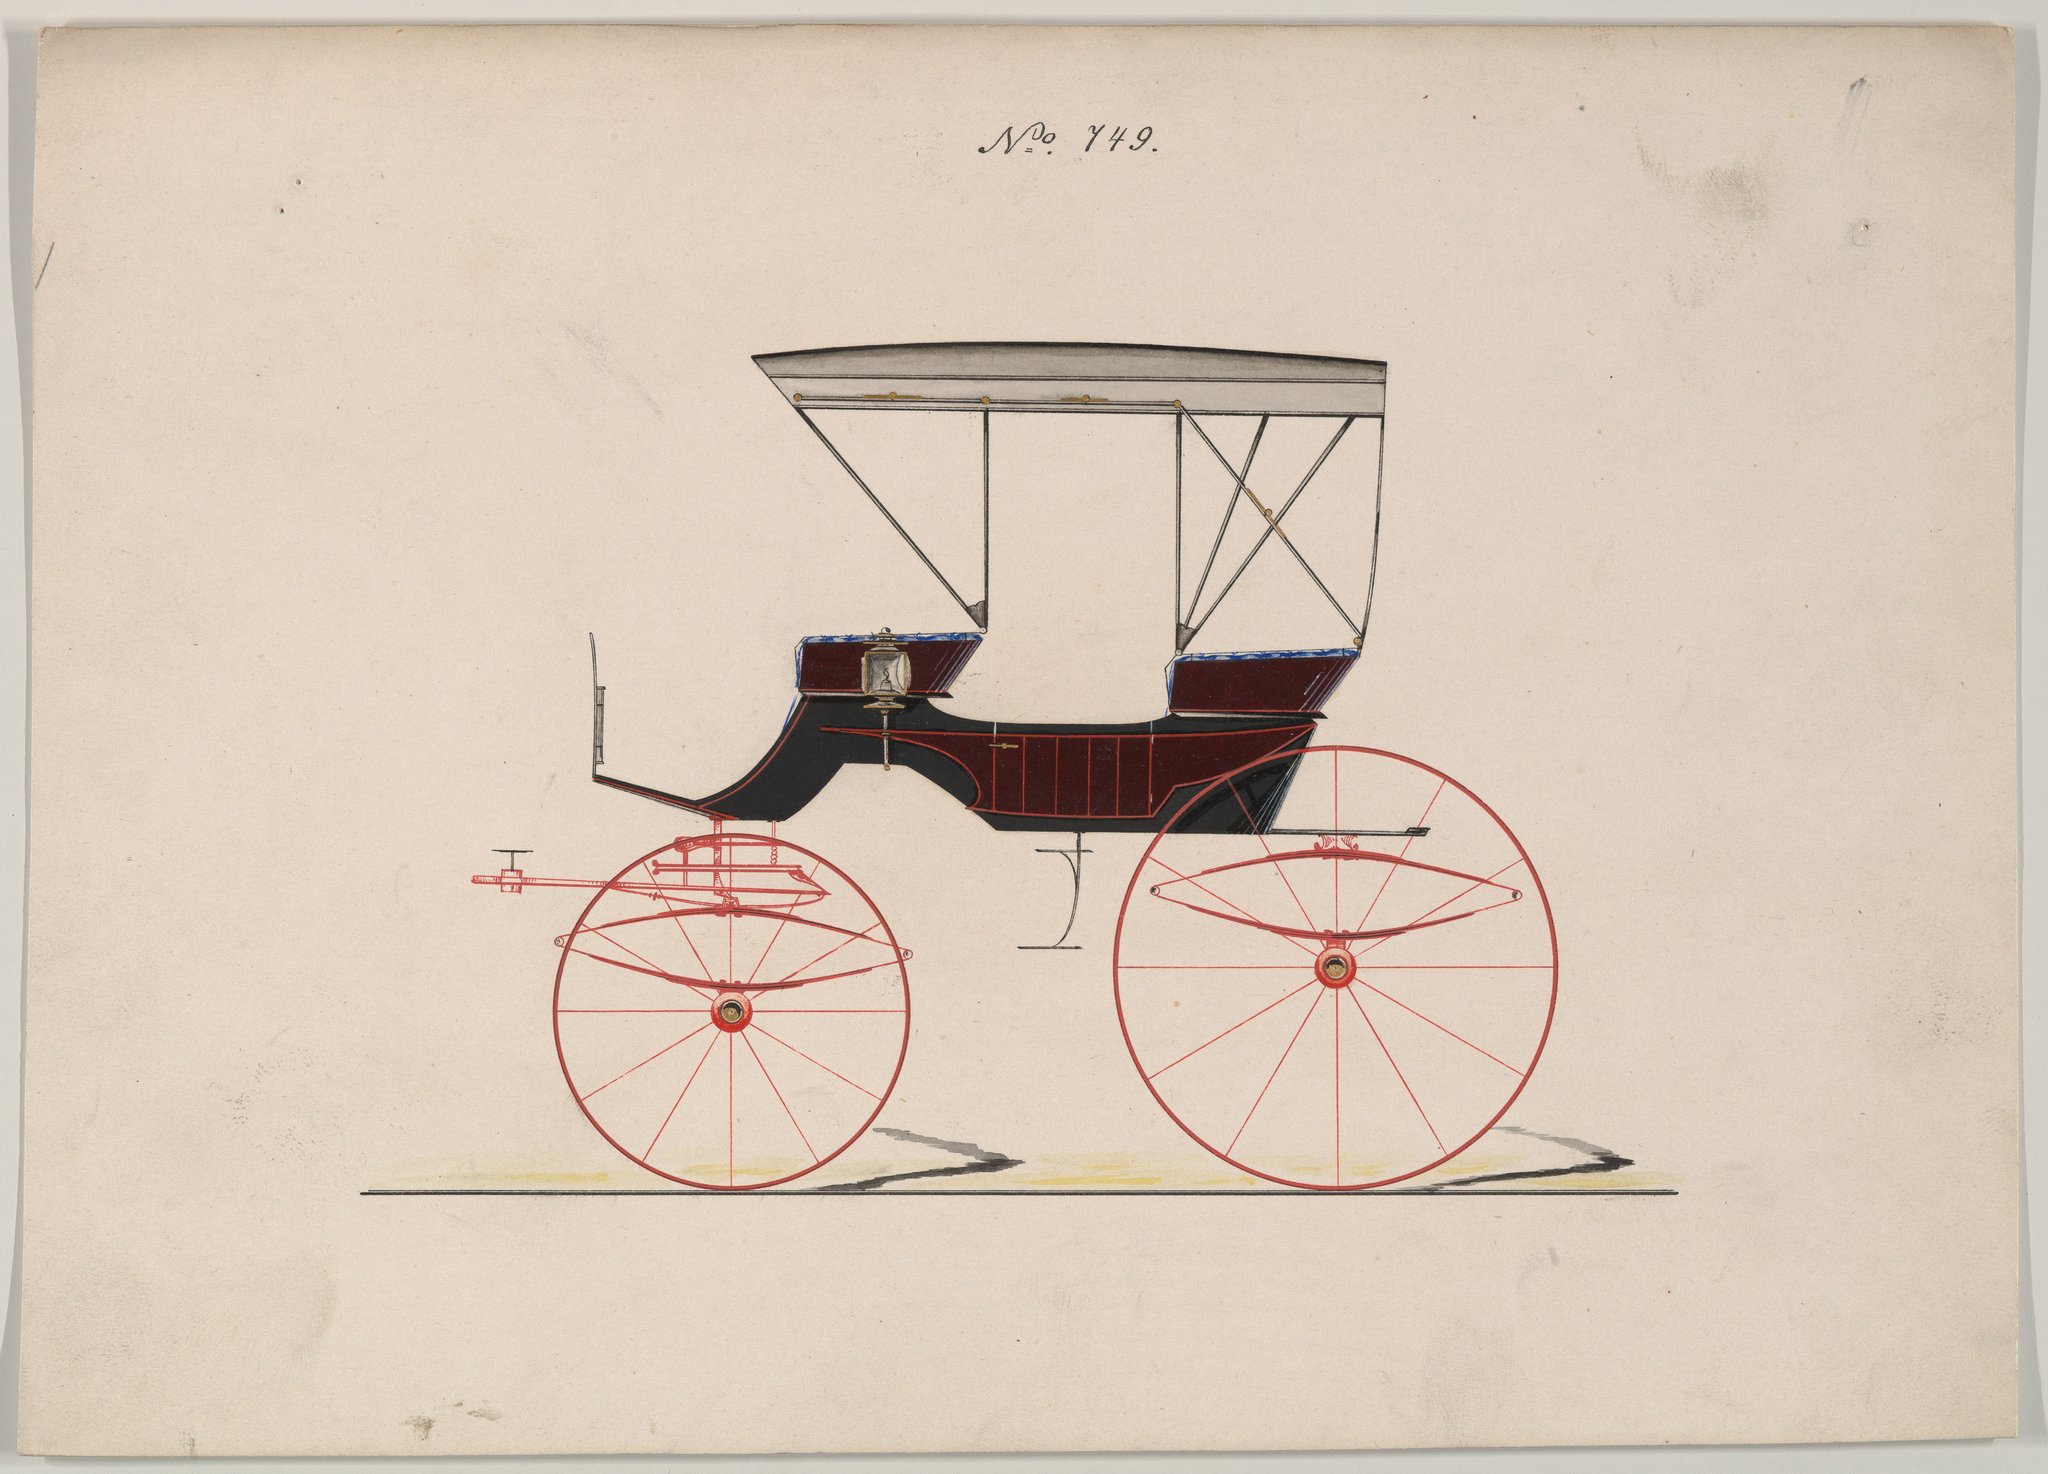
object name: drawing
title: Design for Park Phaeton or Chariotte, no. 749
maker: brewster & co.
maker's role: manufacturer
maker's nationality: american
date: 1850-1874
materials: gouache, gum arabic, ink, watercolor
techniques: pen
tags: carriages